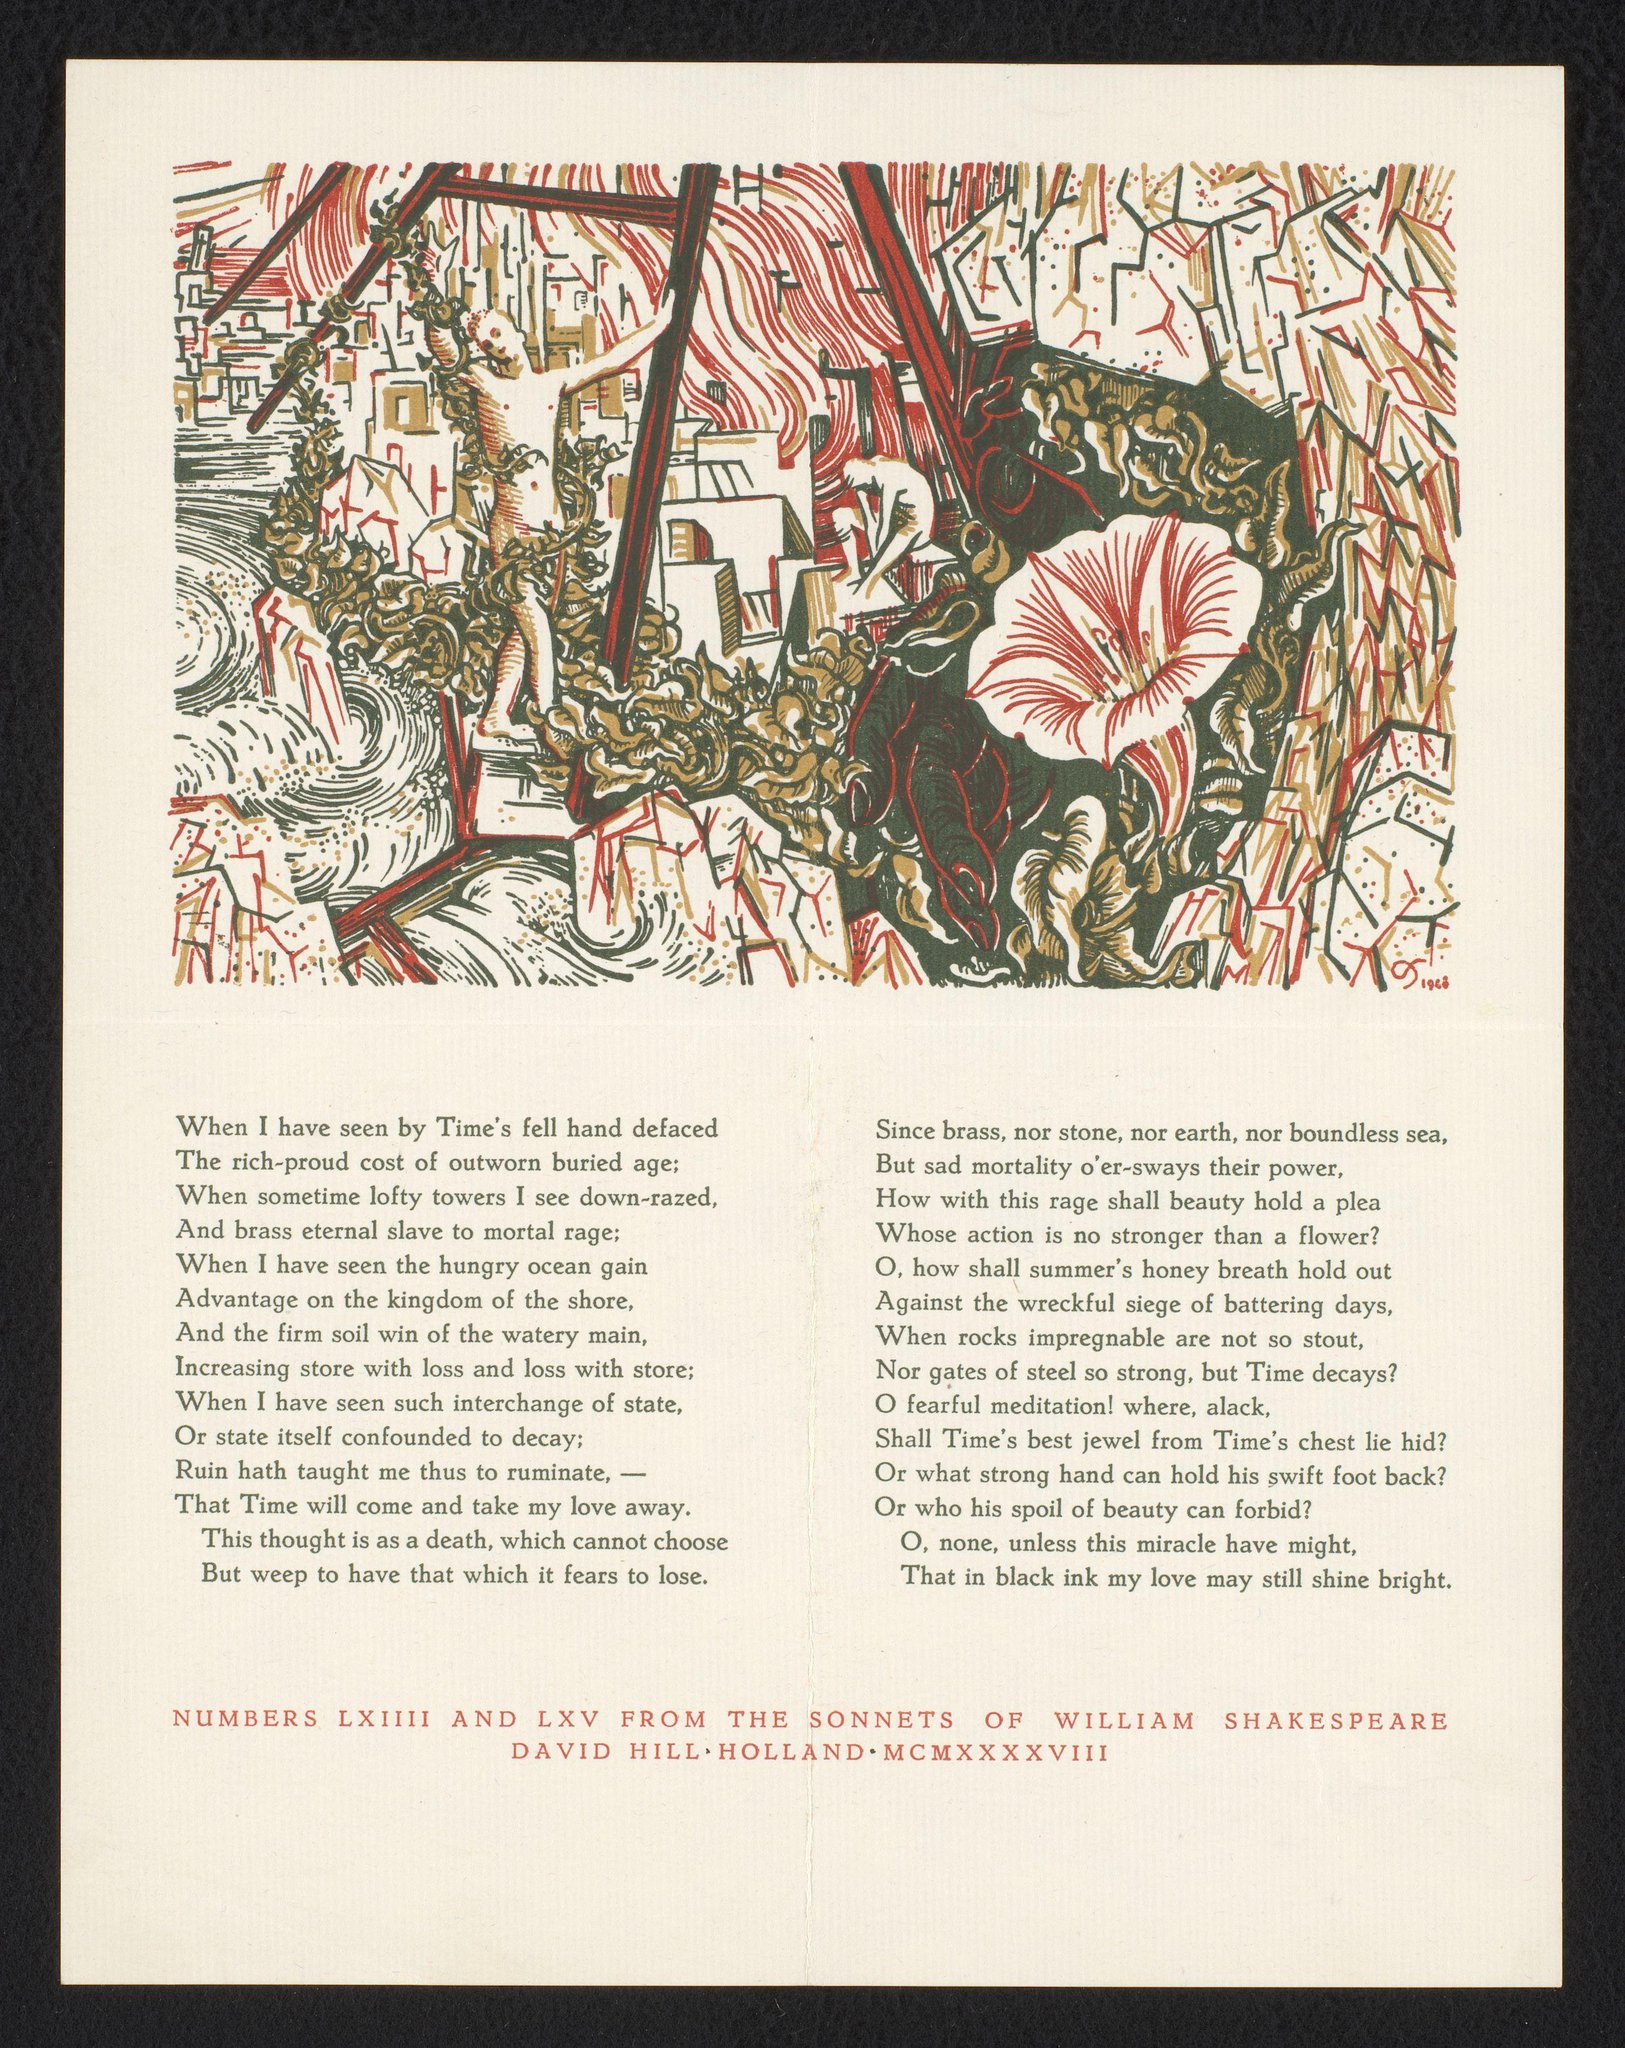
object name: print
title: Figuur omwonden door een plant bij ruïnes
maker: Anonymous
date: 1948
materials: paper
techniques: letterpress printing, relief print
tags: landscape with ruins, man (showing himself) undressed, quasi-nude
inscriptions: date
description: Onder de afbeelding in twee kolommen de twee sonnetten.